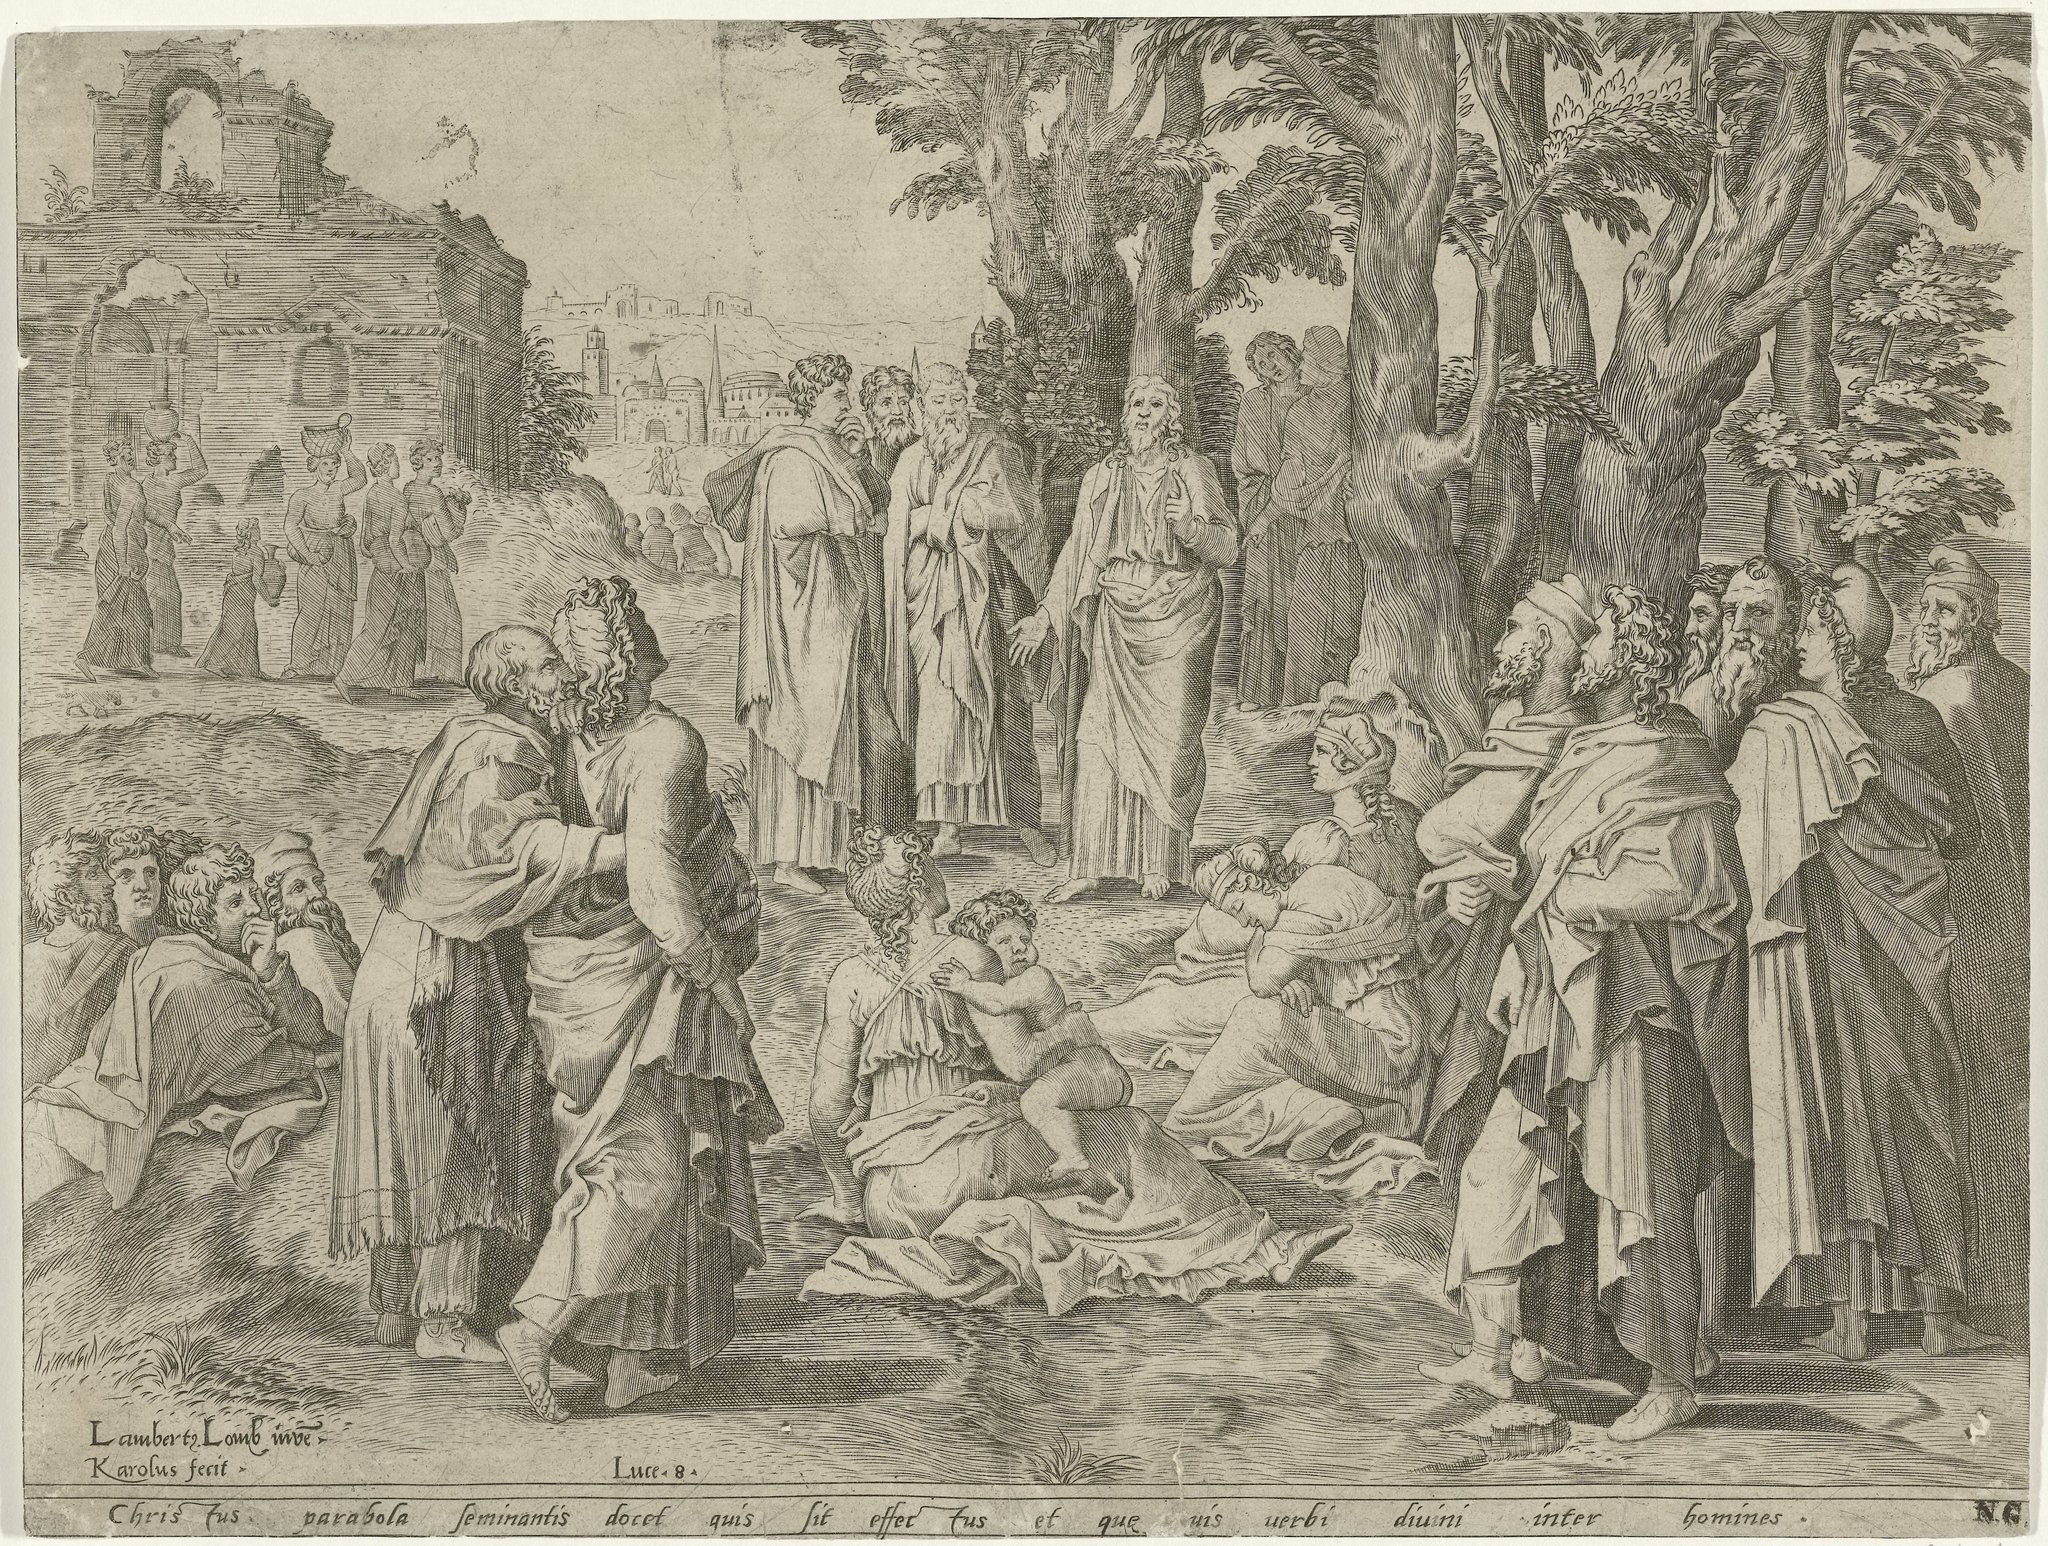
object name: print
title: Prekende Christus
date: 1540-1560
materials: paper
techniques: engraving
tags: the sower ~ parable of christ (matthew 13:3-9; mark 4:3-9; luke 8:5-8), christ preaching in the open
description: Christus vertelt zeer waarschijnlijk de parabel van de zaaier, gezien het Latijnse onderschrift (Lucas 8).